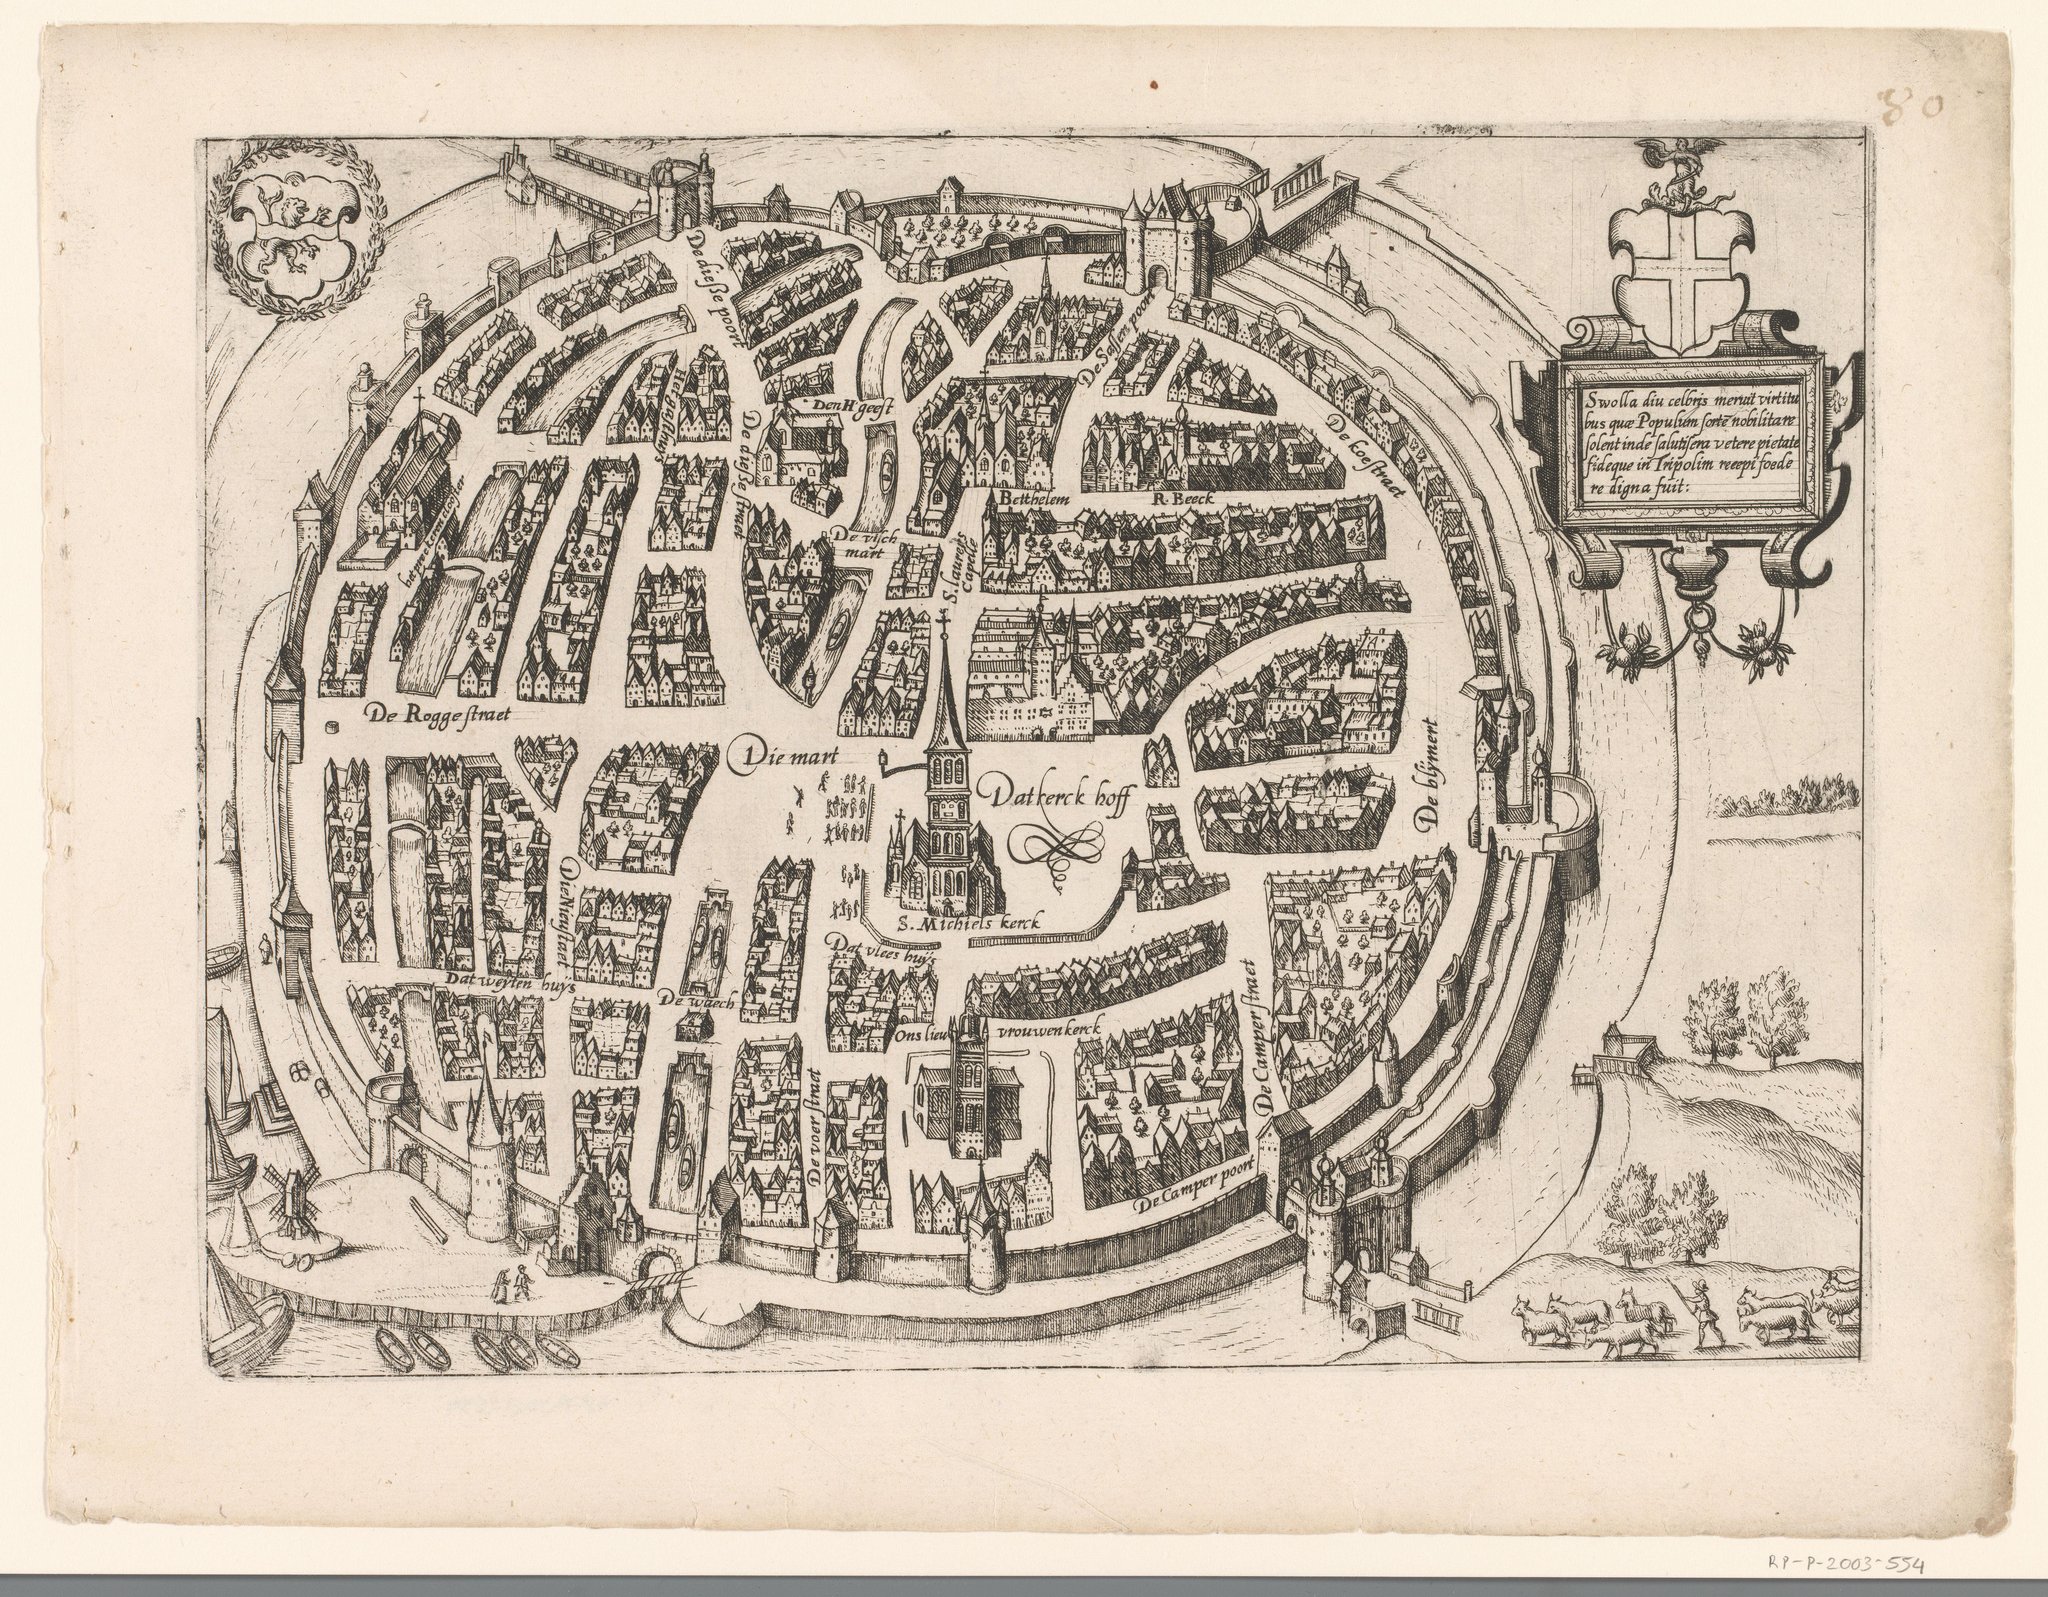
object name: print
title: Swolla diu celbris meruit ...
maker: Anonymous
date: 1607-1609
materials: paper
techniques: etching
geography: southern netherlands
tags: maps of cities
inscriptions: number: ‘80’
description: Plattegrond van de stad Zwolle. Linksboven het wapen van Overijssel, rechtsboven een cartouche met de Latijnse titel en het stadswapen. Onderdeel van de verzameling kaarten genomen uit een latere editie van: Descrittione di tutti i Paesi Bassi van Lodovico Guicciardini.